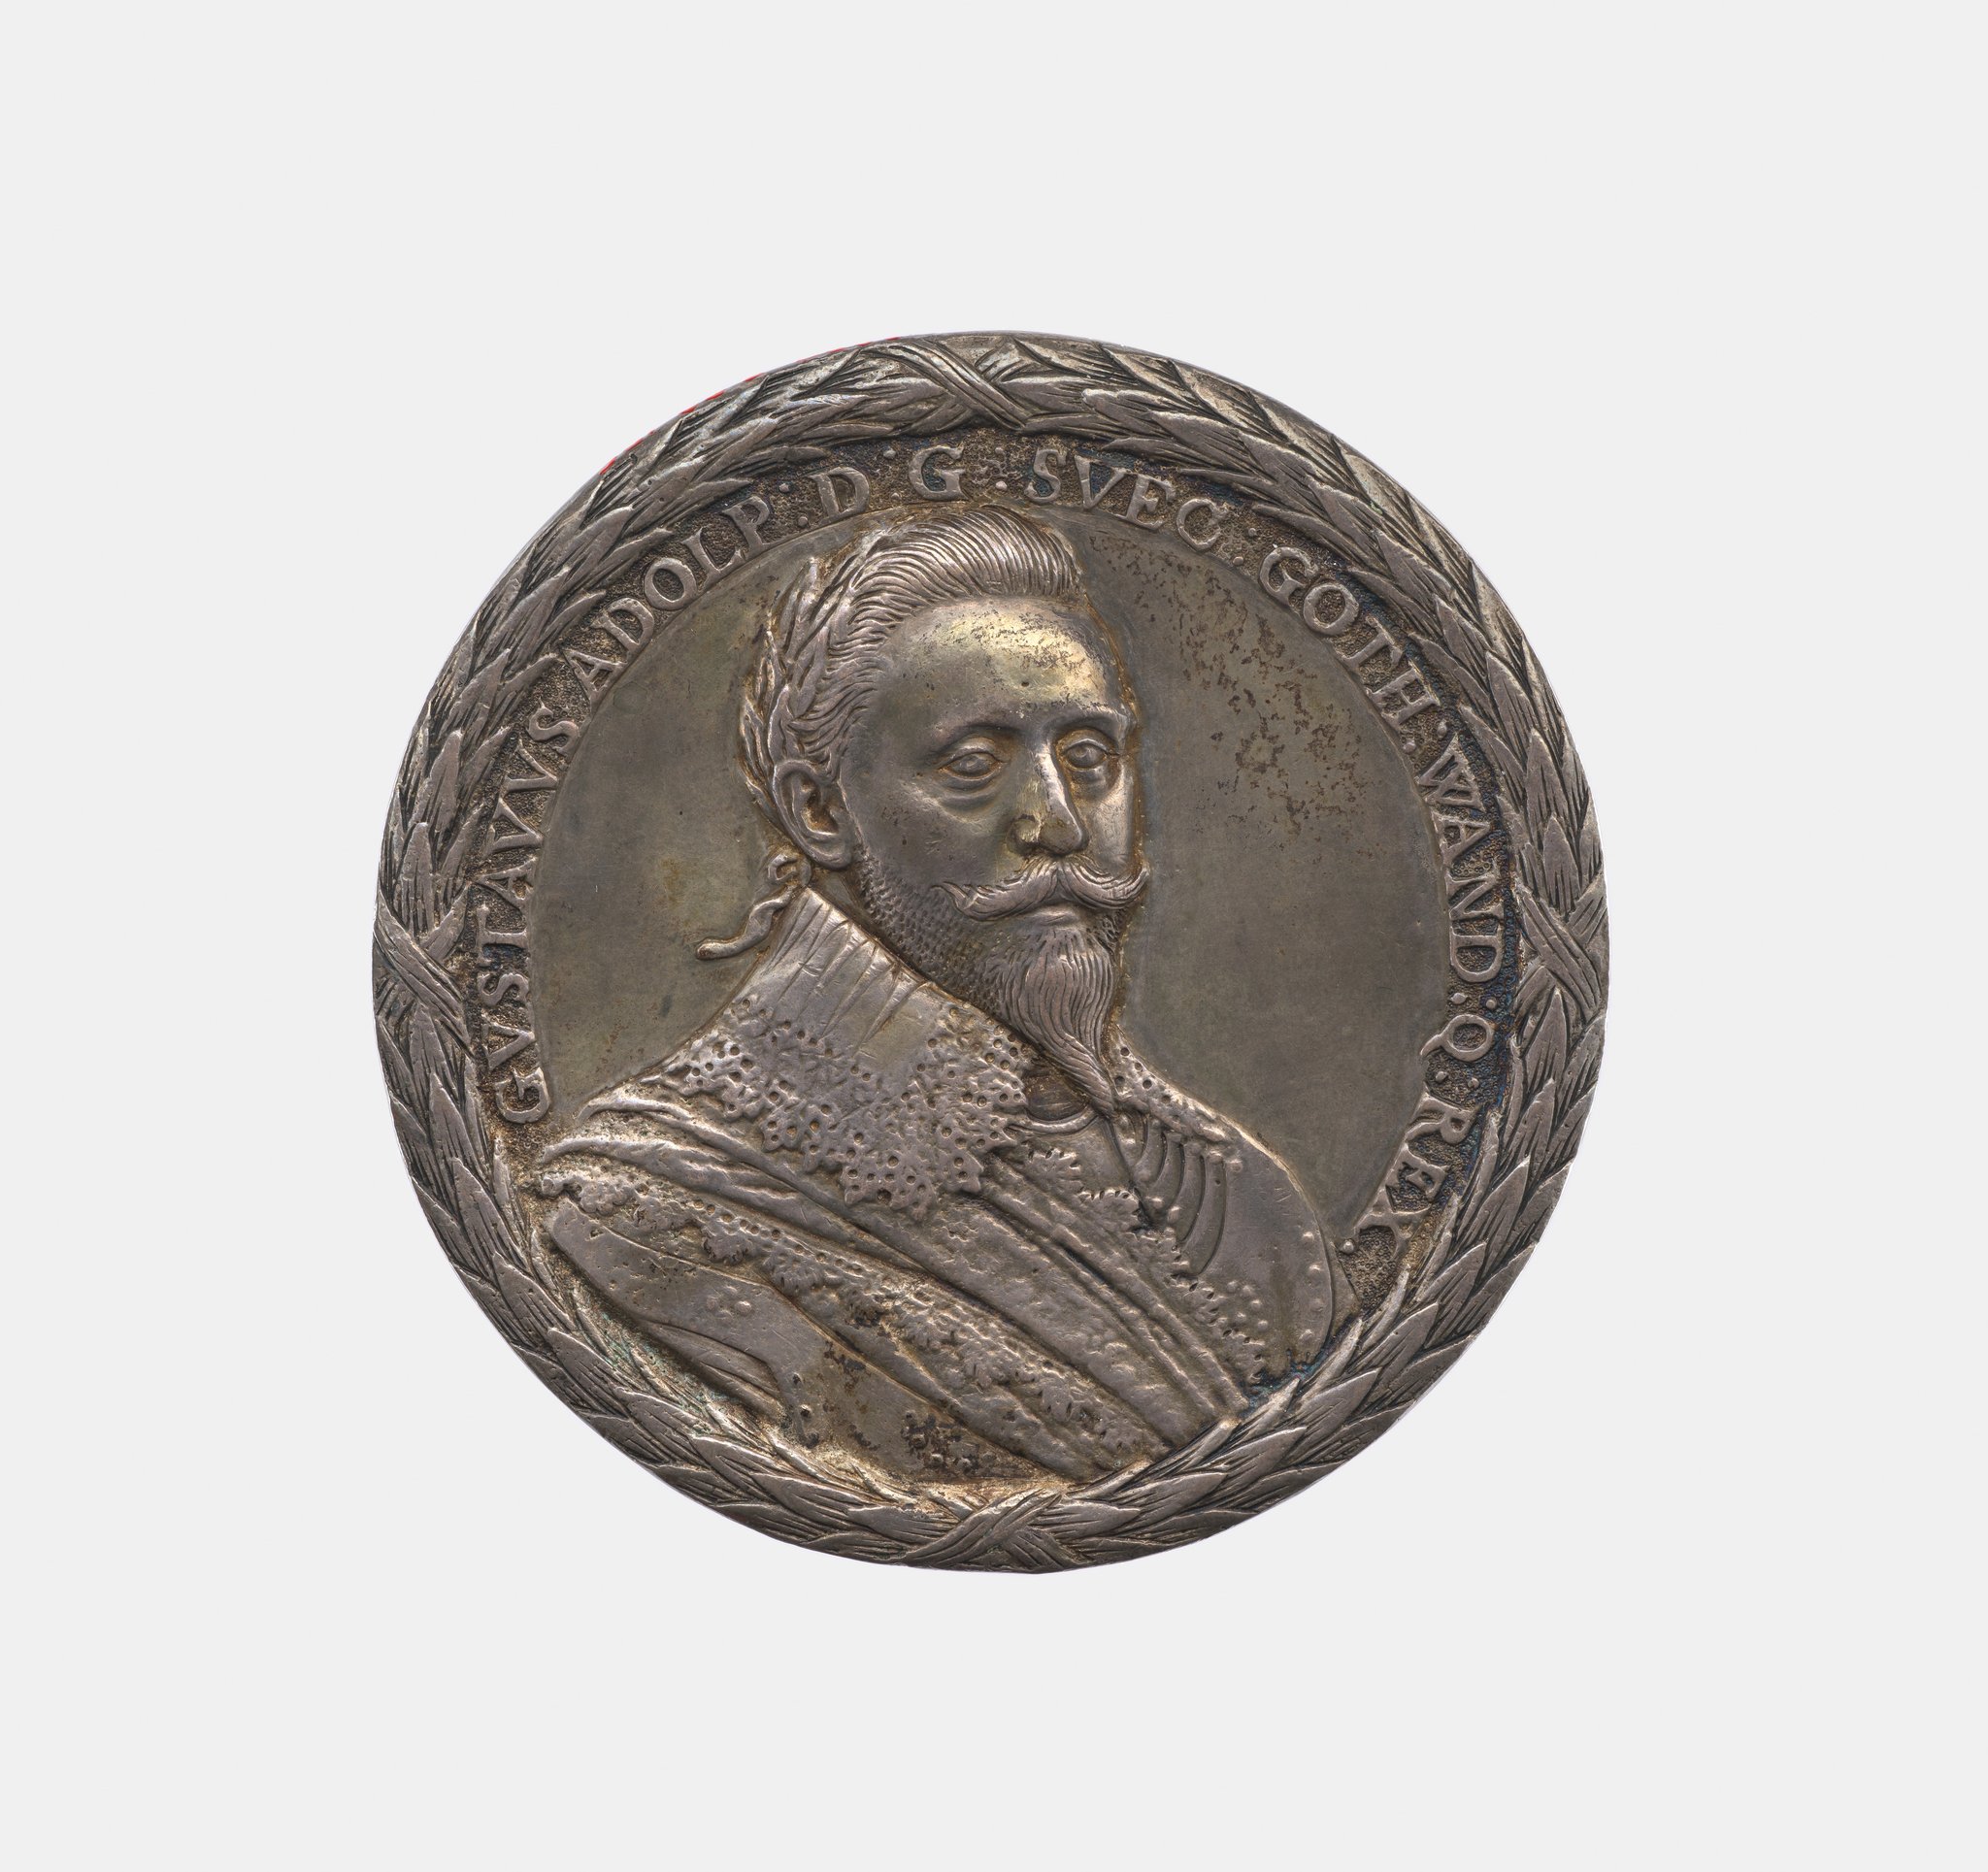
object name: medal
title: Gustav II Adolf 1594-1632, King of Sweden 1611-32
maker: Anonymous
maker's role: artist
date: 1629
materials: silver